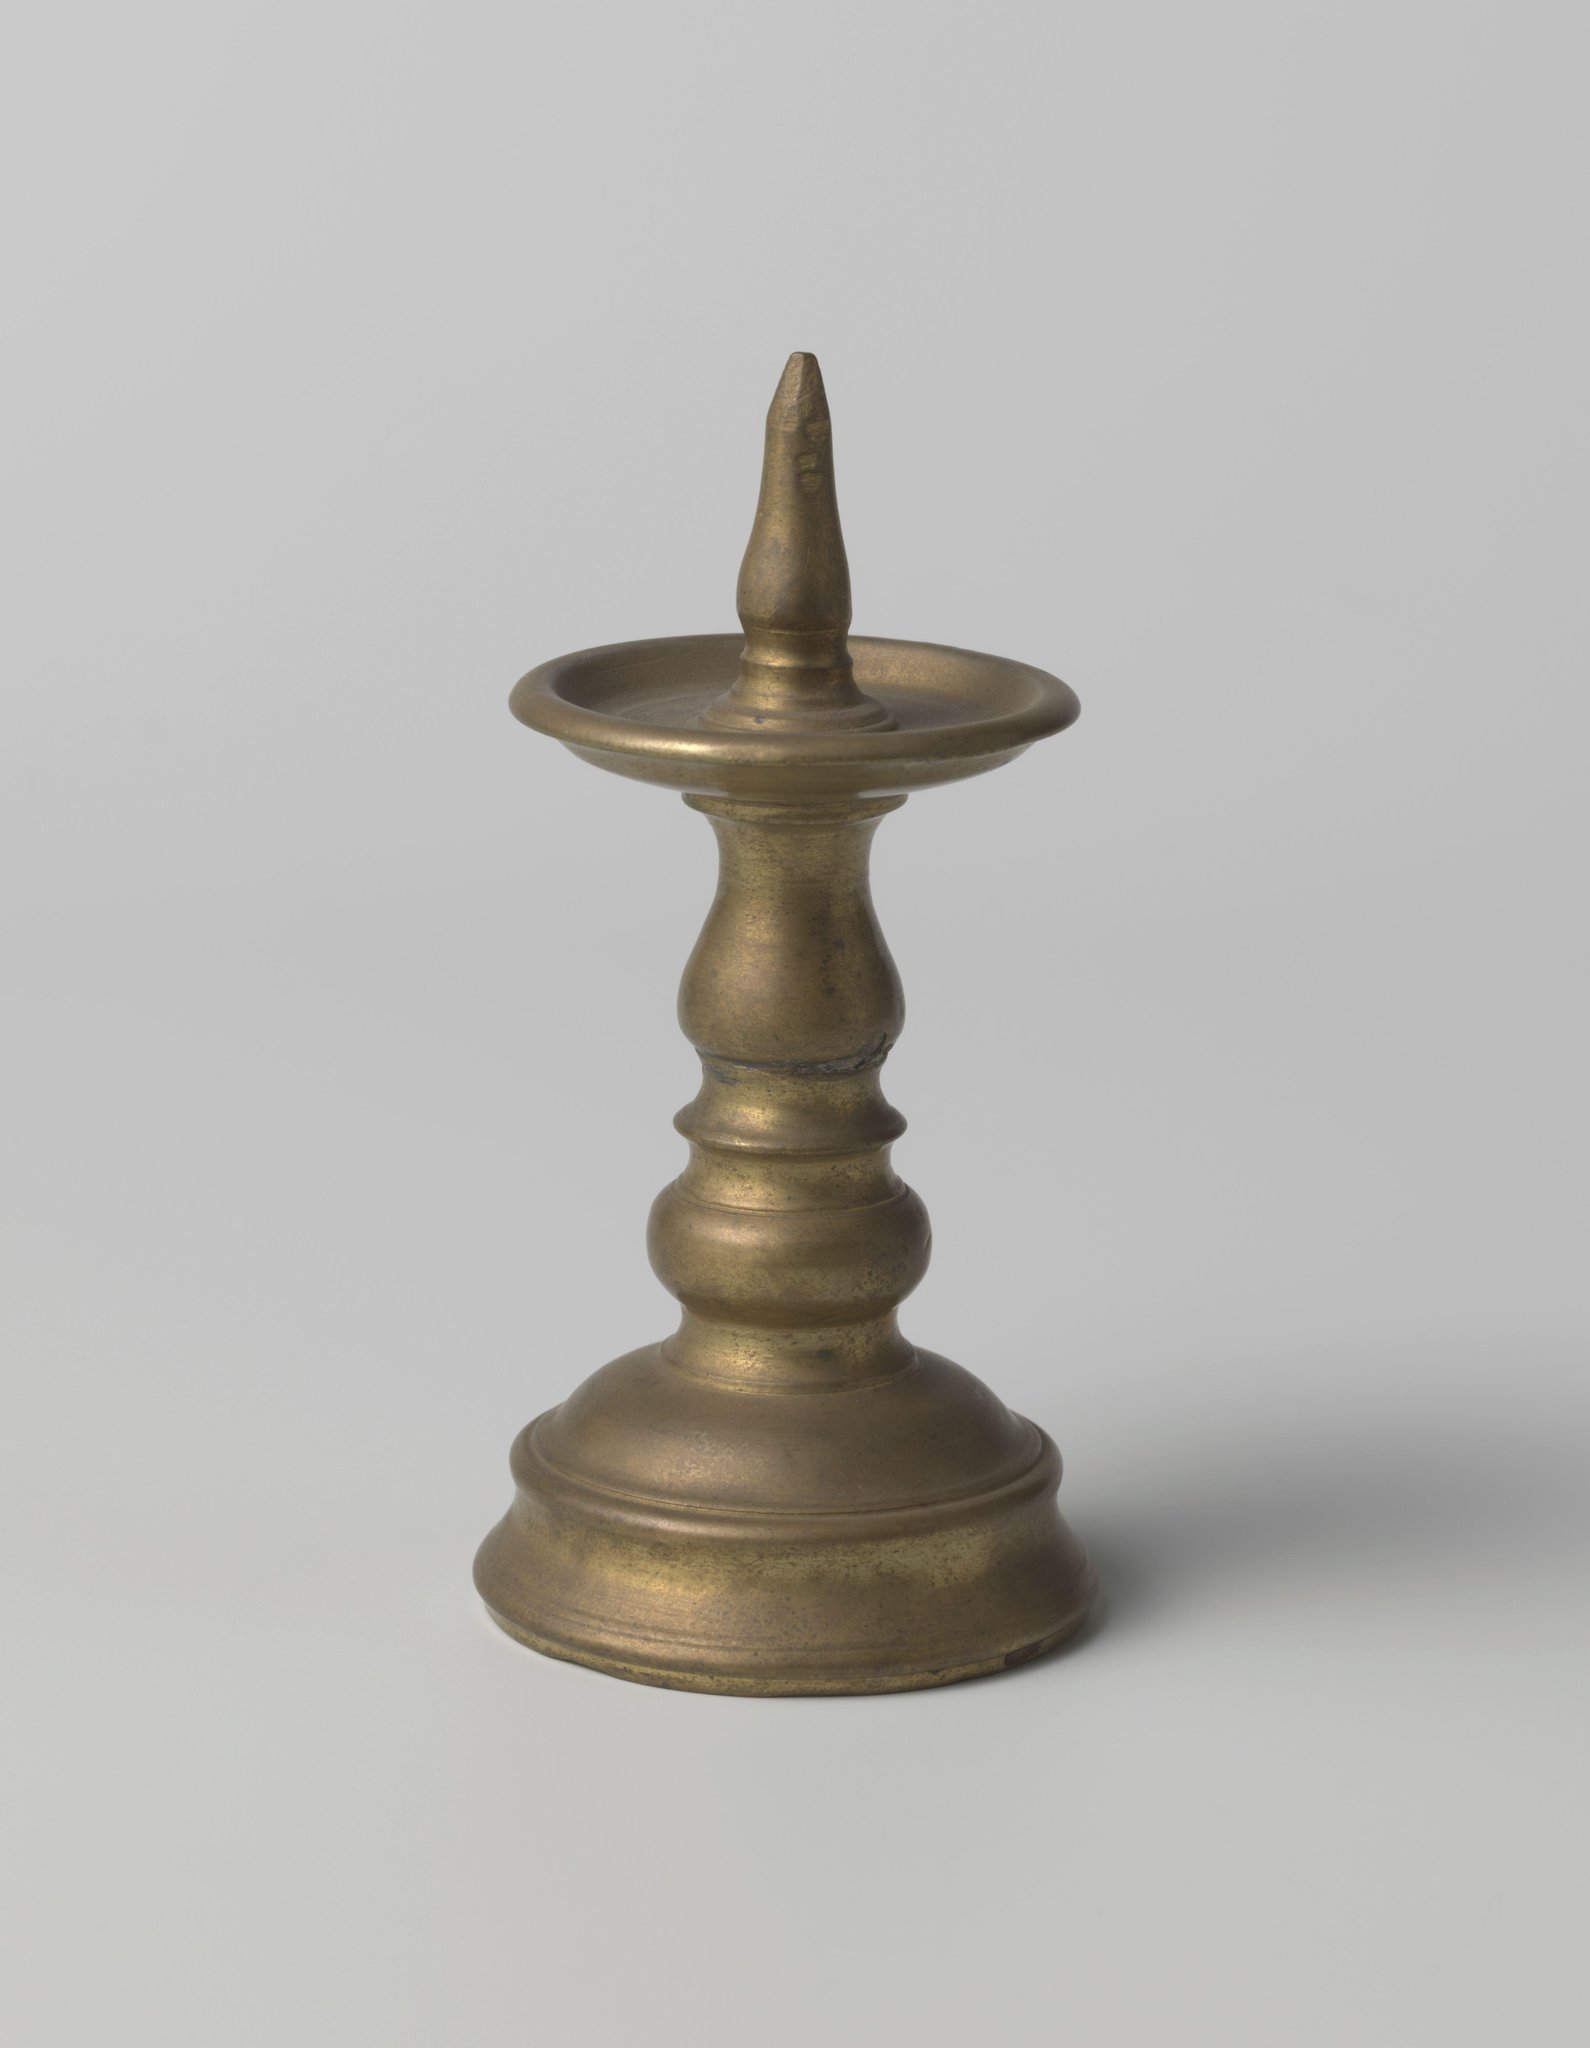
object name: candlestick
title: Kandelaar van messing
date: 1600-1700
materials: brass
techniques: casting, turning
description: Het voorwerp, dat in één geheel gegoten is, heeft een ronde voet, een enigszins bol- en balustervormig geprofileerde stam, een ronde vetvanger en een bij de aanzet geprofileerde kaarsenpin. Binnenin wordt de ronde holle stam gemarkeerd door vier groeven op onderling gelijke afstand, dienende om de draaibank houvast te verschaffen. Het object vertoont kleine verschillen met kandelaar BK-NM-2289-A.